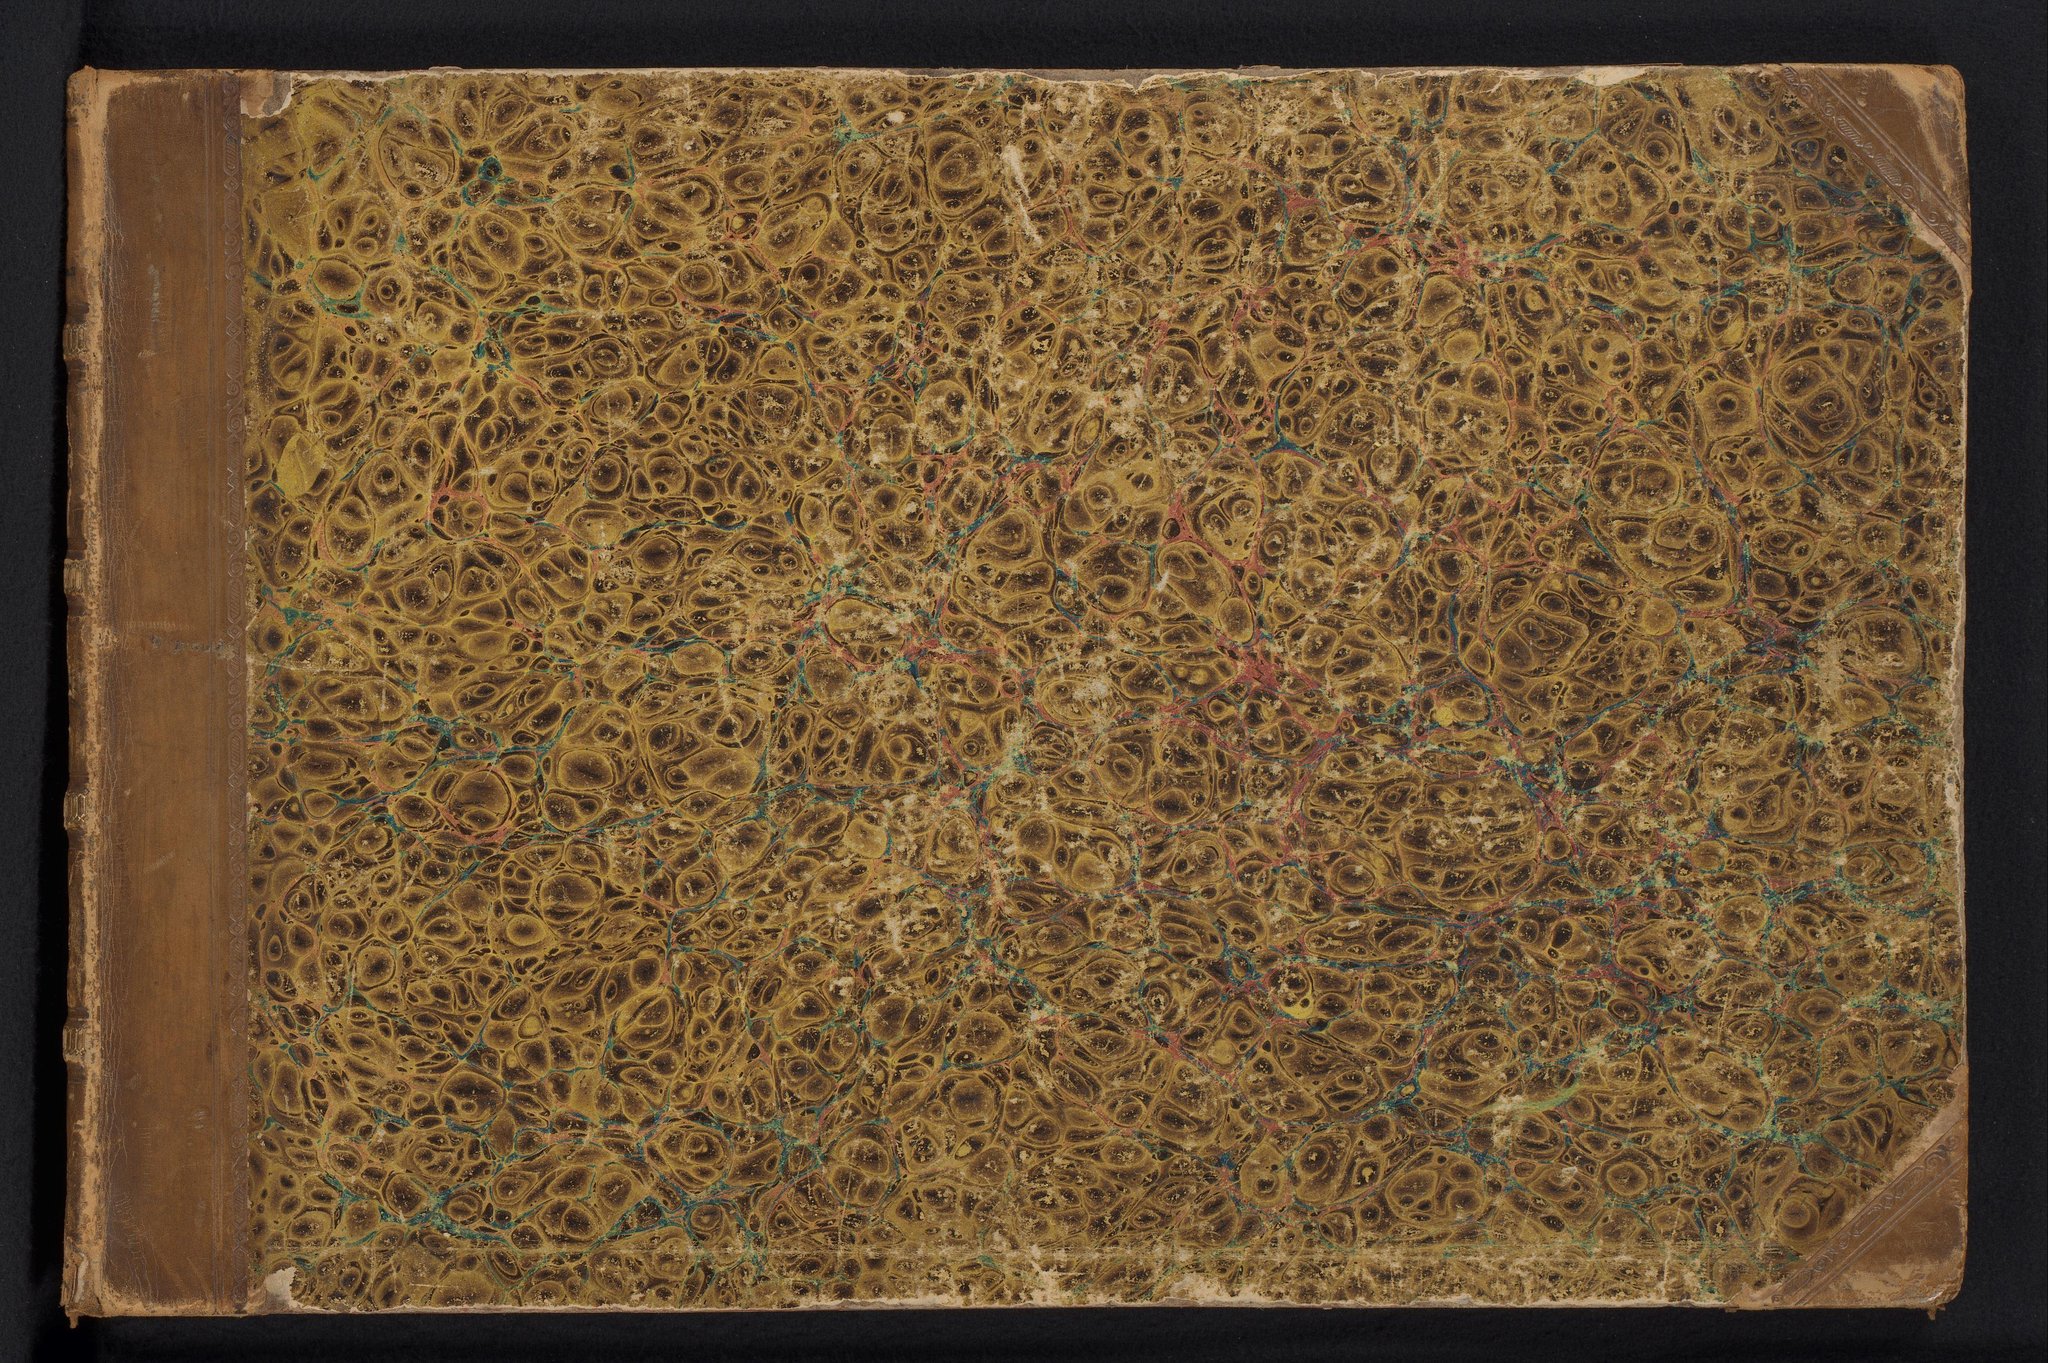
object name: prentrecueil, prentenalbum, prentalbum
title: Album met ornamenteel alfabet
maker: lorenzo lorenzi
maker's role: painter, print maker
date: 1745-1765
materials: cardboard, leather, paper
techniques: bookbinding, printing, engraving, etching, marbling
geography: italy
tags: letters, alphabet, script, fancy letters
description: Album met titelprent en 24 etsen met de ornamentele letters van het alfabet. De kapitalen zijn versierd met menselijke figuren, dieren, vogels en fantasiefiguren. Een kartonnen band, beplakt met leer en groen marmerpapier. In het leer is met goud gestempeld. Voor- en achterin zit een schutblad van rood marmerpapier.